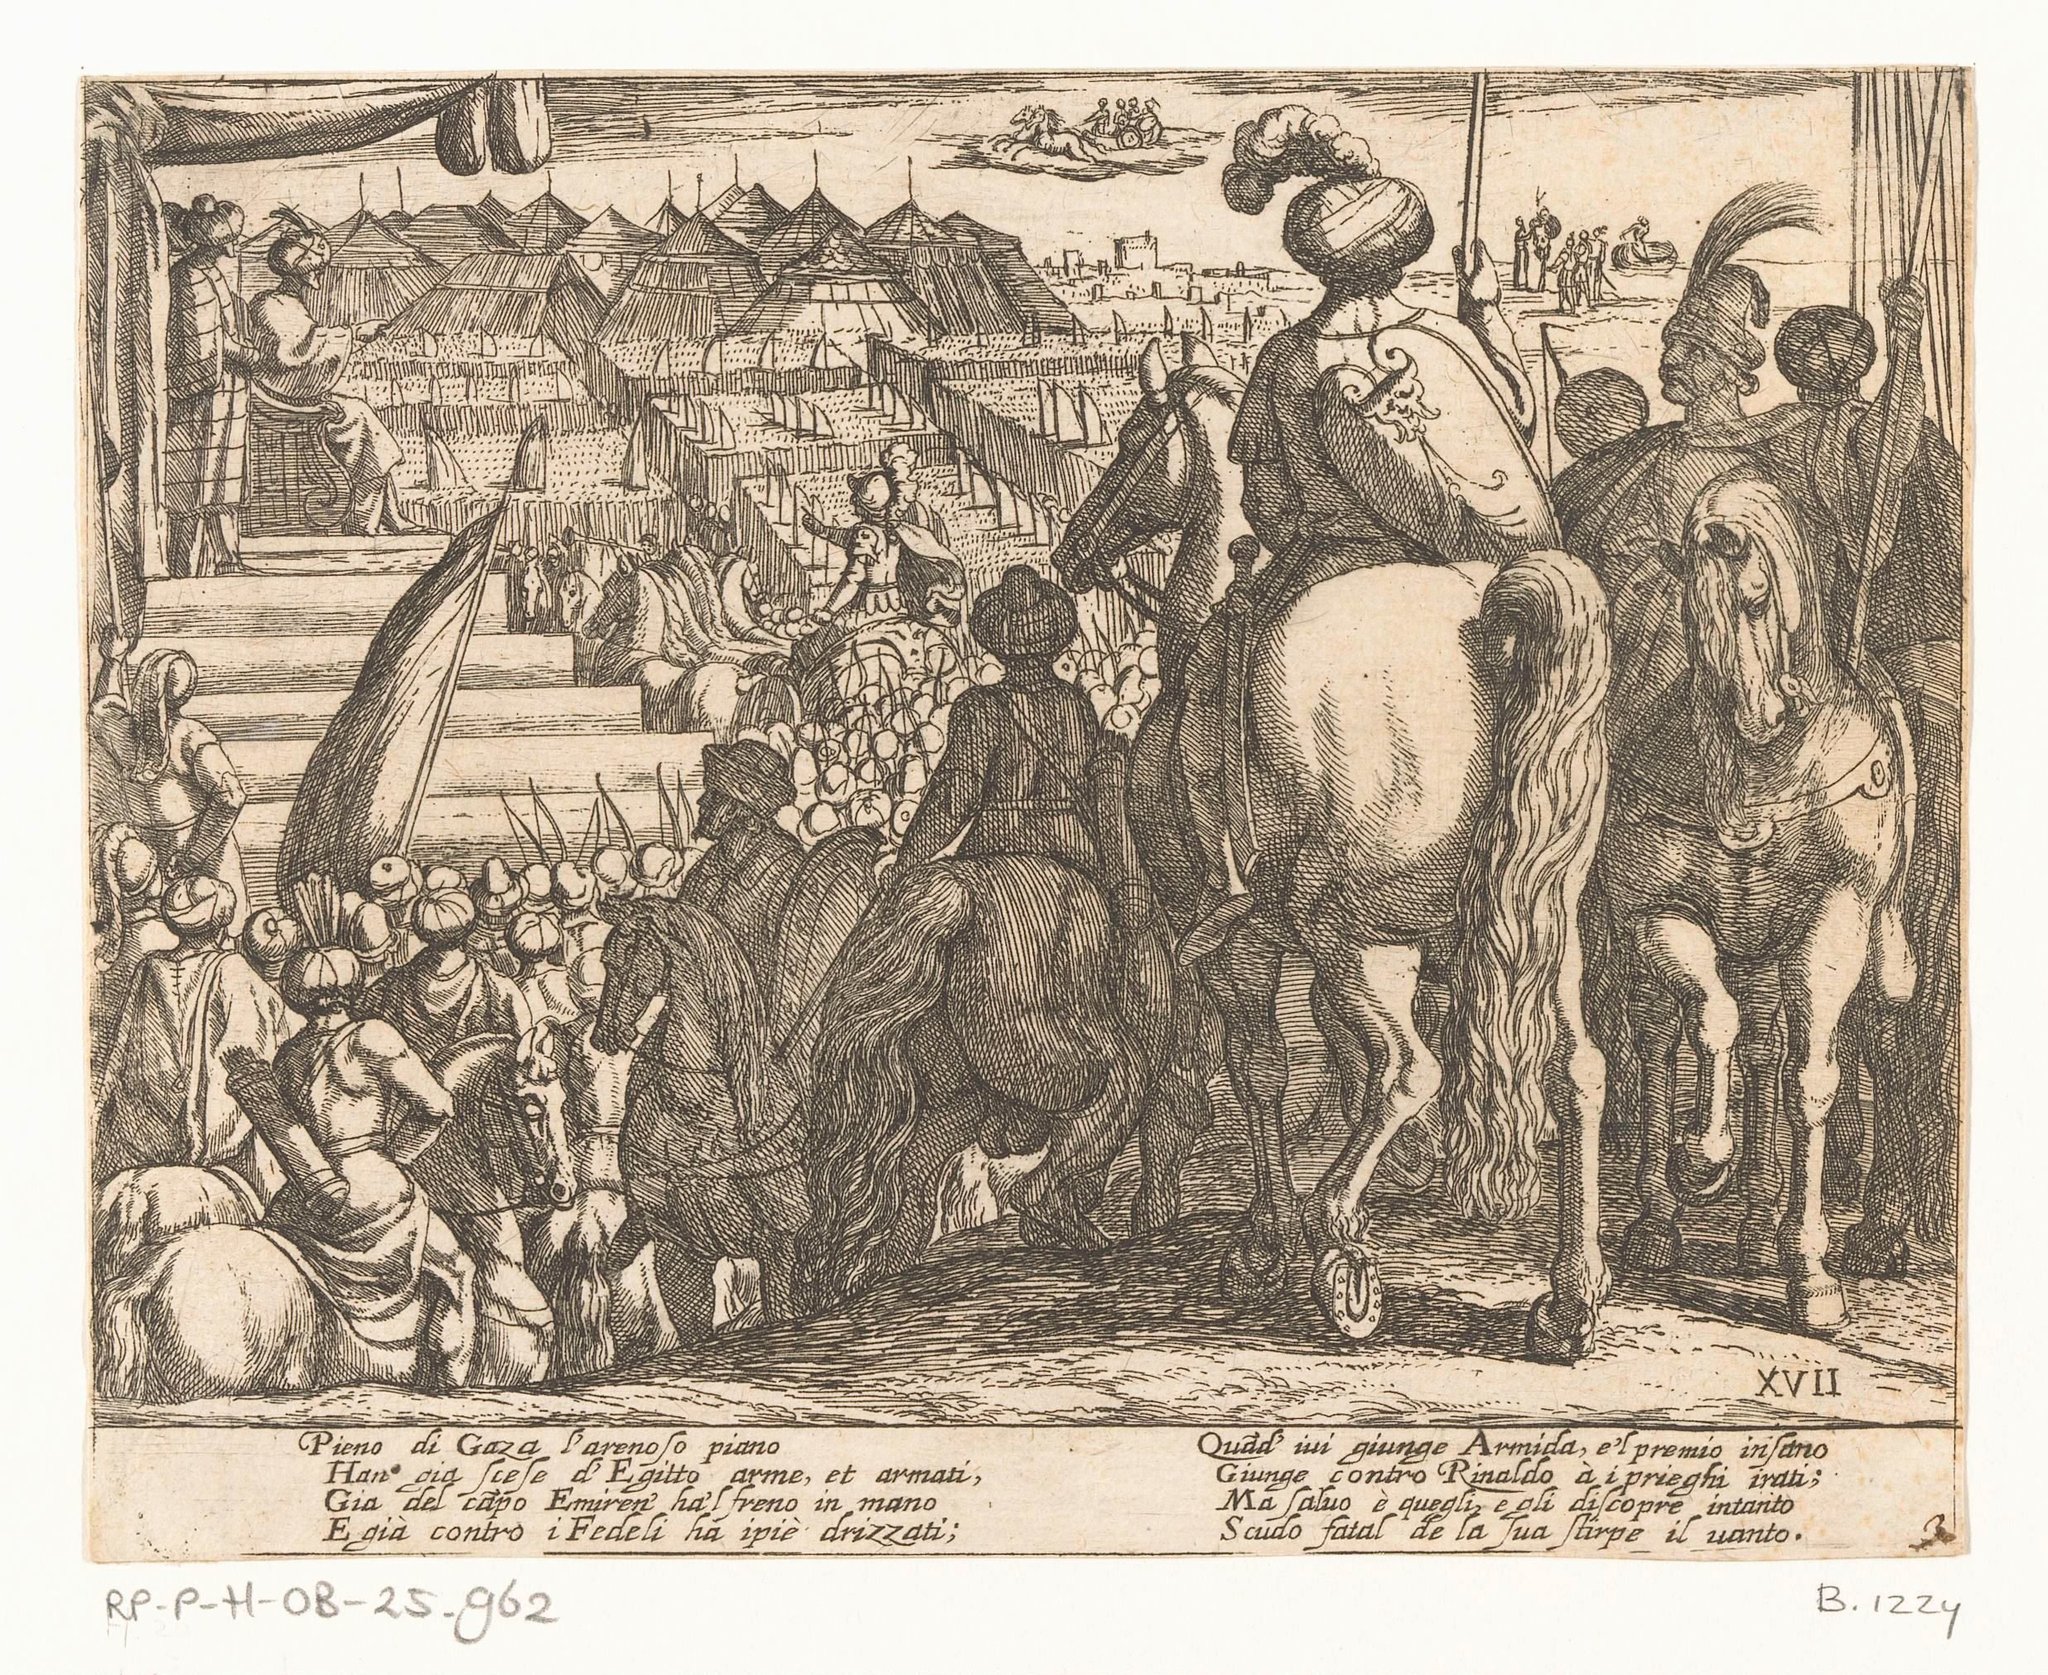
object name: print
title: Jeruzalem verlost (deel 2)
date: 1565-1630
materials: paper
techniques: etching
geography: italy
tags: militant proselytizing: religious war, crusade, etc., (scenes from) specific works of literature: tasso, gerusalemme liberata, knight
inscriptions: collector's mark: ‘Hinloopen’, number: ‘3’, collector's mark: Lugt 11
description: Deze prent maakt deel uit van een reeks van twintig prenten (+ opdracht) met voorstellingen van scènes uit Tasso's 'Jeruzalem verlost', een episch gedicht geschreven door de Italiaanse dichter Torquato Tasso en voor het eerst gepubliceerd in 1581. Het verhaal vertelt grotendeels in fictie over de Eerste Kruistocht waarin de christenen, geleid door Godfried van Bouillon, de strijd aangaan met de moslims om het Beleg van Jeruzalem.